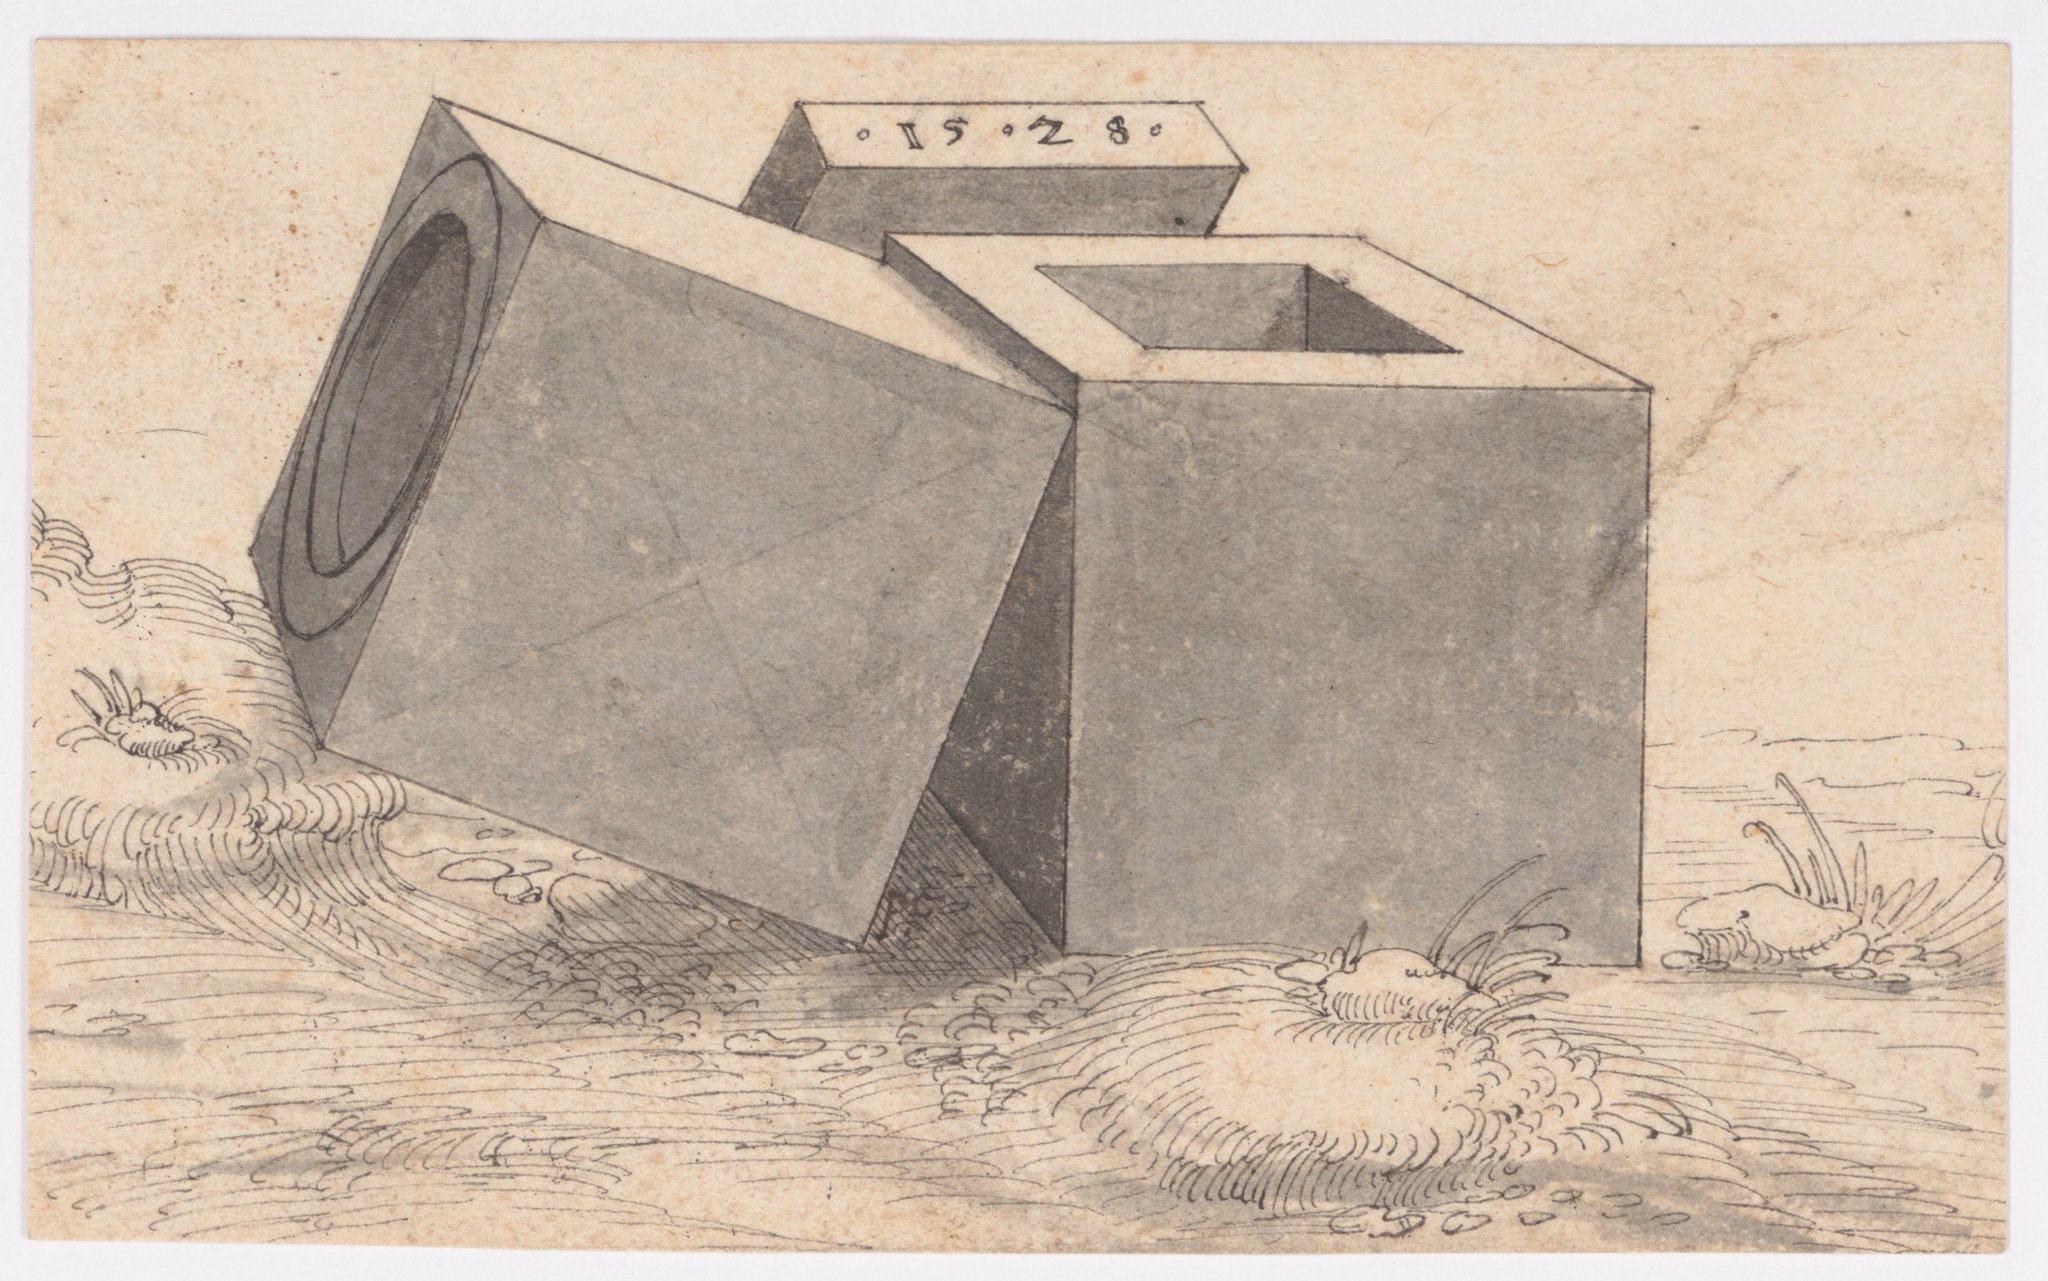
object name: drawing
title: Perspectival Drawing with Three Cubes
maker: peter flötner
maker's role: artist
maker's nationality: german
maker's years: 1485-1546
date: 1528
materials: ink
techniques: brush, pen, wash